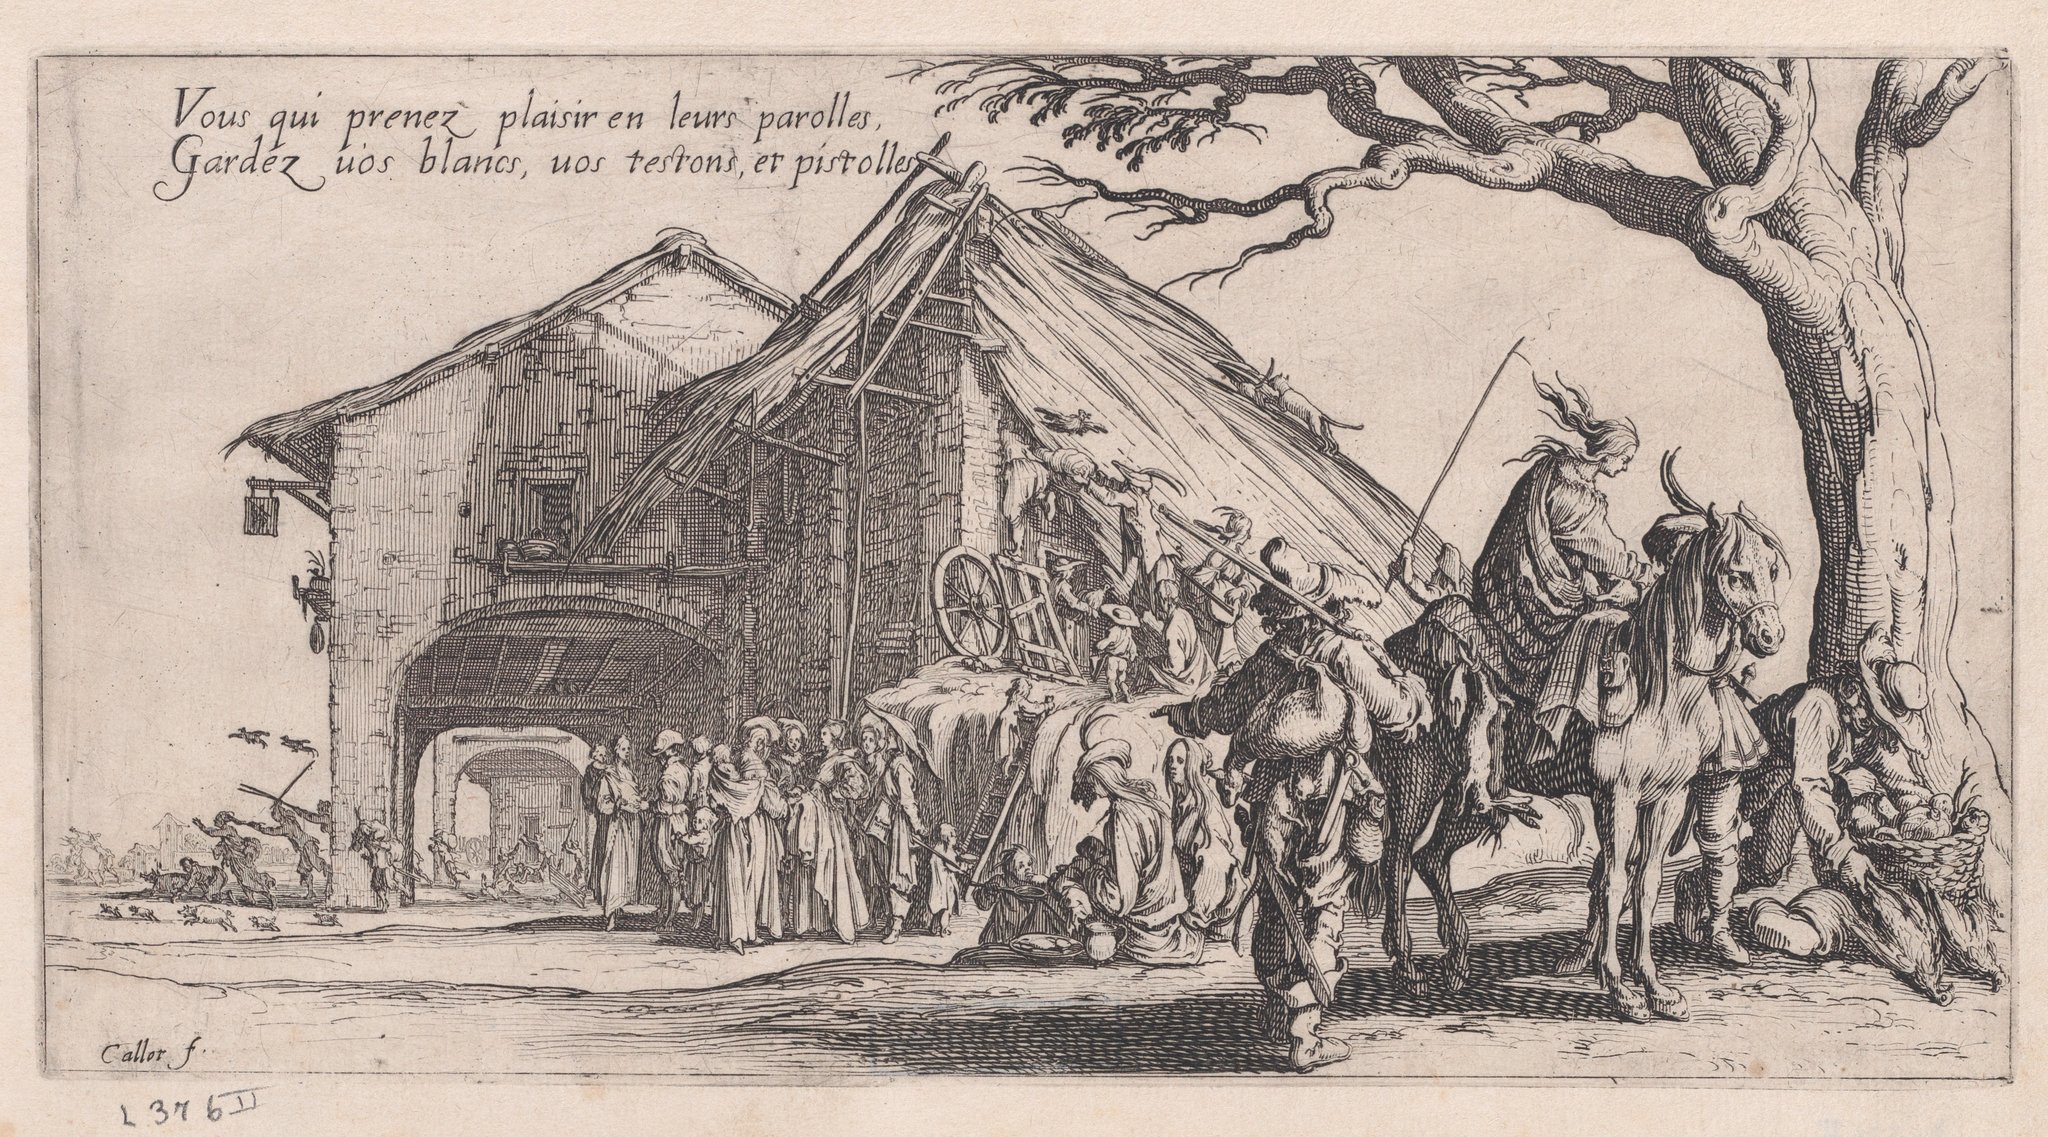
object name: print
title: La Halte des Bohèmiens: Les Diseuses de Bonne Aventure (The Gypsy Stopover: The Fortune Tellers), from "Le Bohémiens, série appelée aussi Les Égyptiens, La Marche des Bohémiens, La Vie Errante des Bohémiens, Les Marches Égyptiennes" (The Gypsies, series also called The Egyptiens, The Gypsy Troops, The Wandering Lives of Gypsies, The Egyptian Troops)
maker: jacques callot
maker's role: artist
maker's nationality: french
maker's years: 1592-1635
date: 1601-1633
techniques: engraving, etching